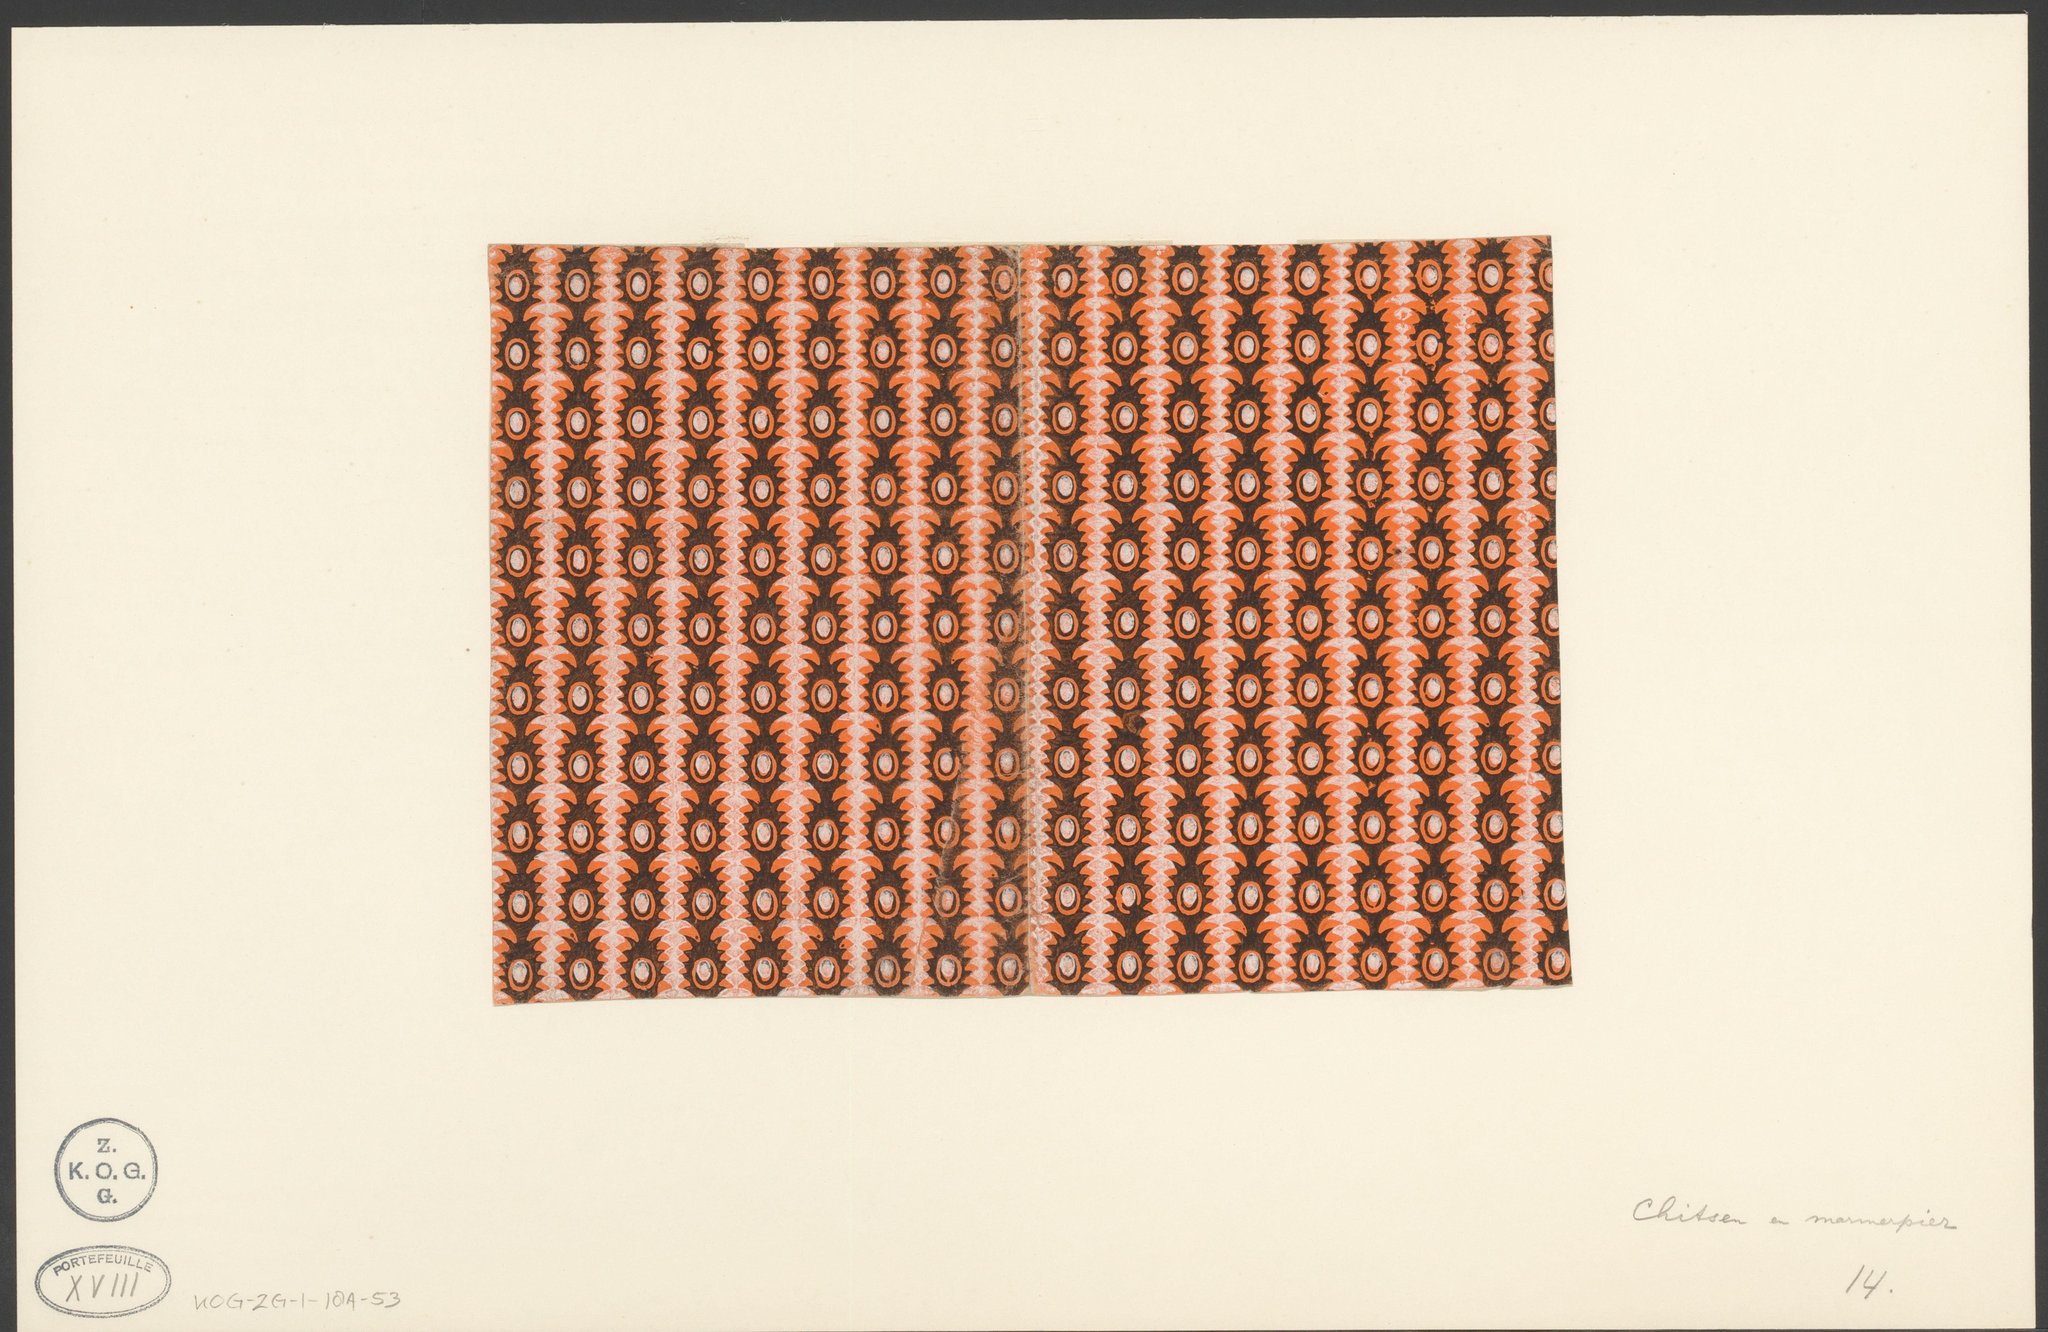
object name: drawing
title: Ontwerp voor een sits met palmmotief en ovalen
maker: Anonymous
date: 1750-1799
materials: textile, paint, paper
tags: flowers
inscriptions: collector's mark: Lugt 1641, stamp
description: Onderwerpsrubrieken binnen de Atlas Zeden en Gewoonten: Schoone kunsten, Sitsen en marmerpapier.